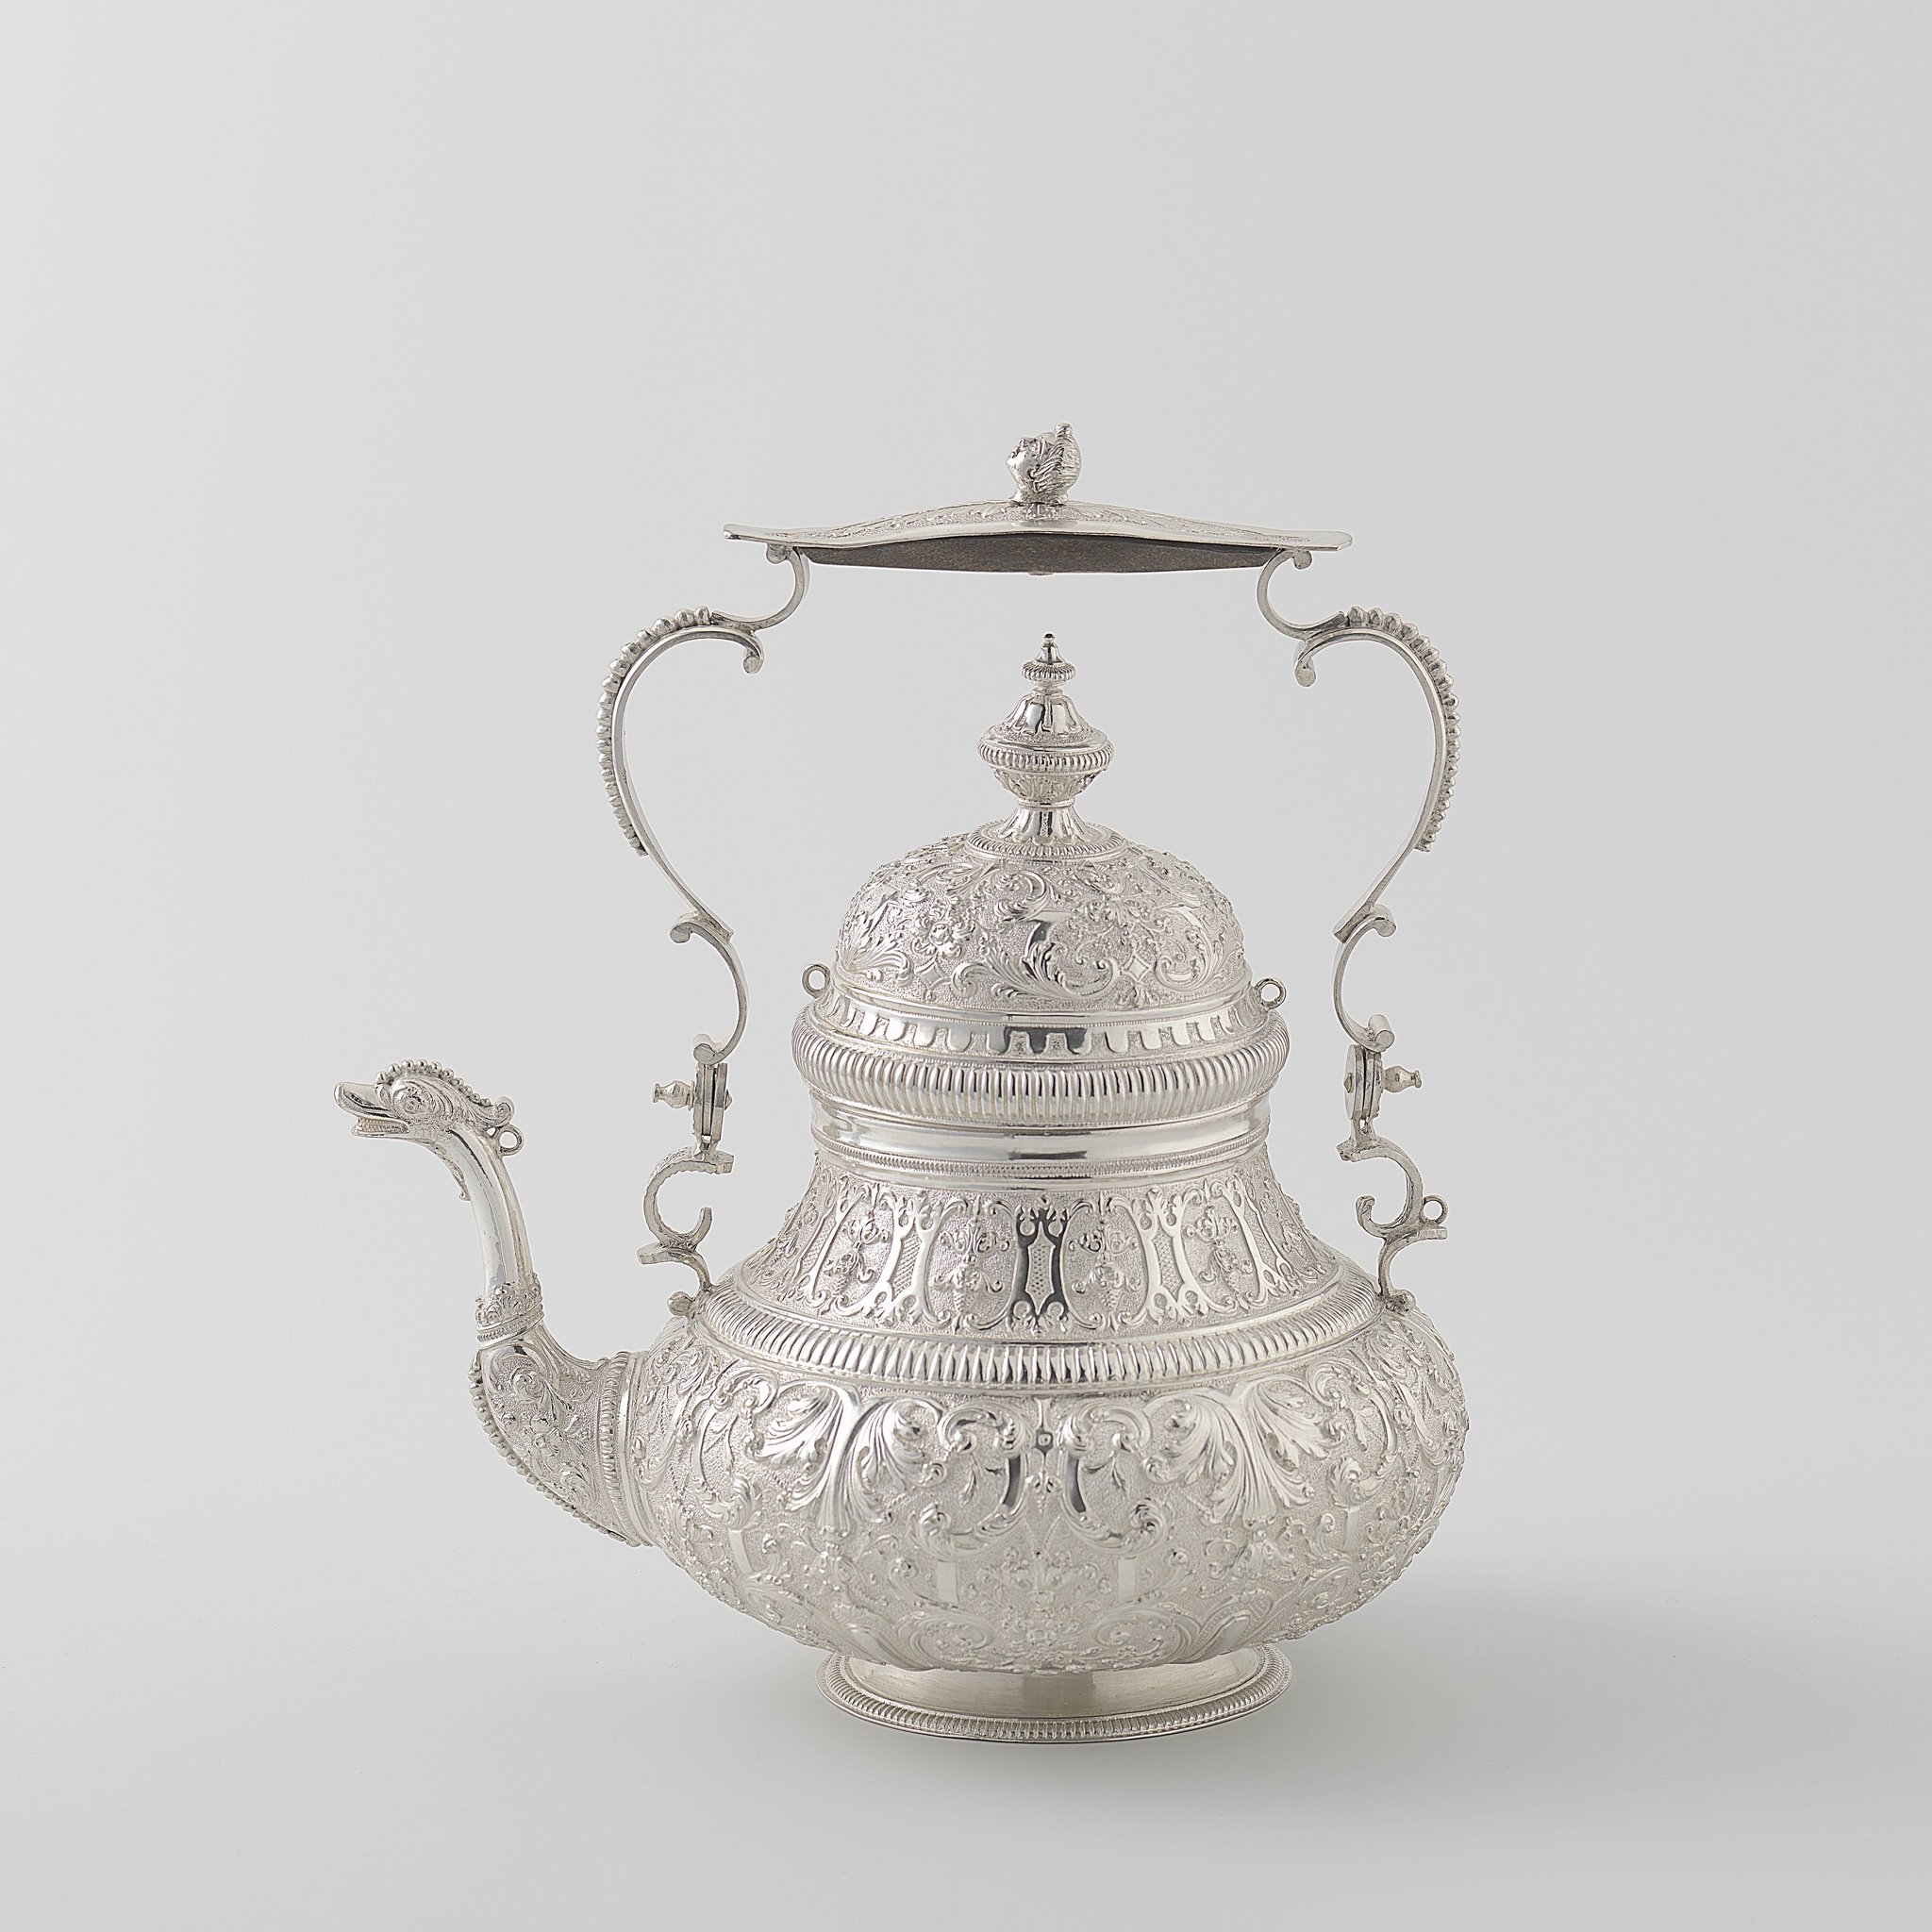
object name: teakettle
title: Theeketel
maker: gabijnus van der lely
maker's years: -1754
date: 1738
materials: wood, silver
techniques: granulation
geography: leeuwarden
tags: dragon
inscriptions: alloy mark, date letter, maker's mark, town mark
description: Tea kettle. Silver. Leeuwarden, 1738, by Gabynus van der Lely.